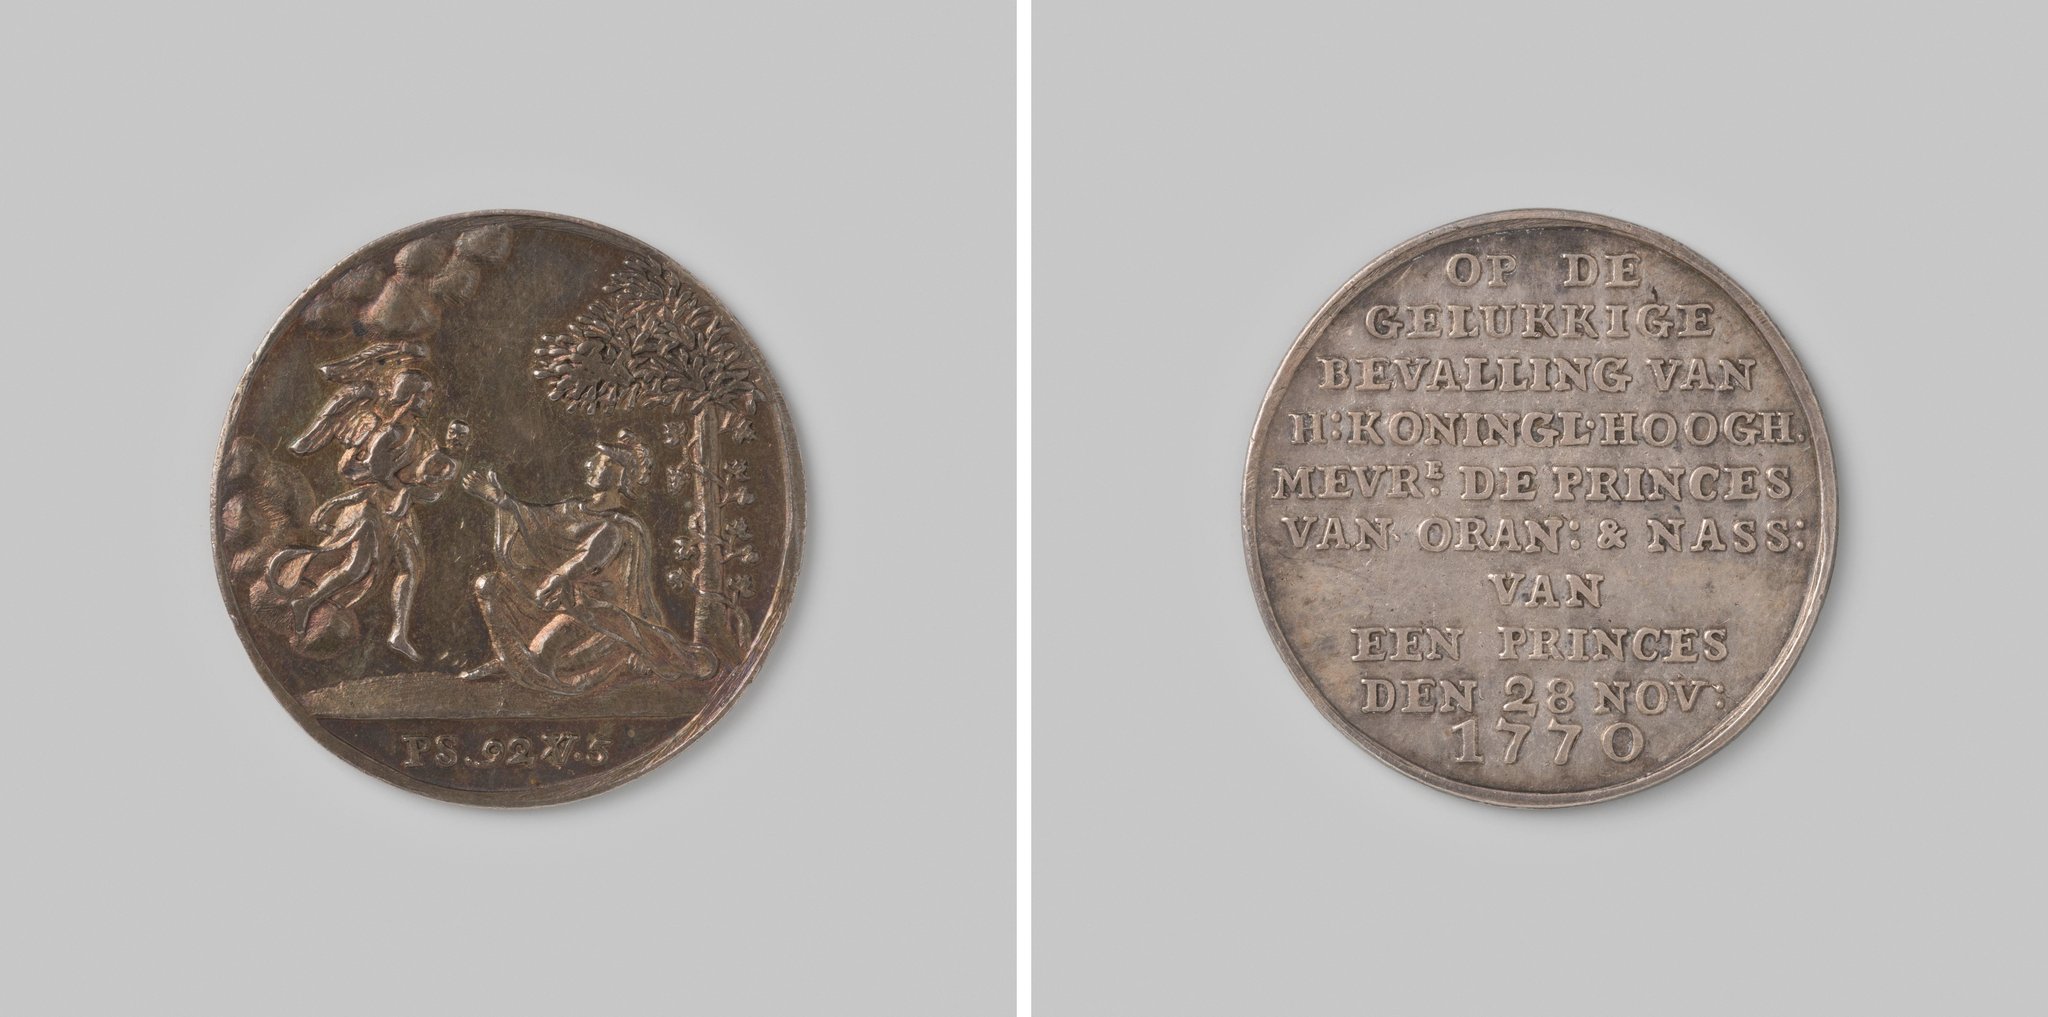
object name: history medal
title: Geboorte van erfprinses Louisa van Oranje 1770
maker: jan willem marme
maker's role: medailleur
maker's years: -1826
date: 1770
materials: silver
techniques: striking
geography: utrecht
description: Zilveren penning, op de voorzijde een engel uit de wolken neerdalend om een kind te brengen aan de Nederlandse Maagd, zittend onder een bom omslingerd door wijnrank, met afsnedetekst, op de keerzijde tien regels tekst.